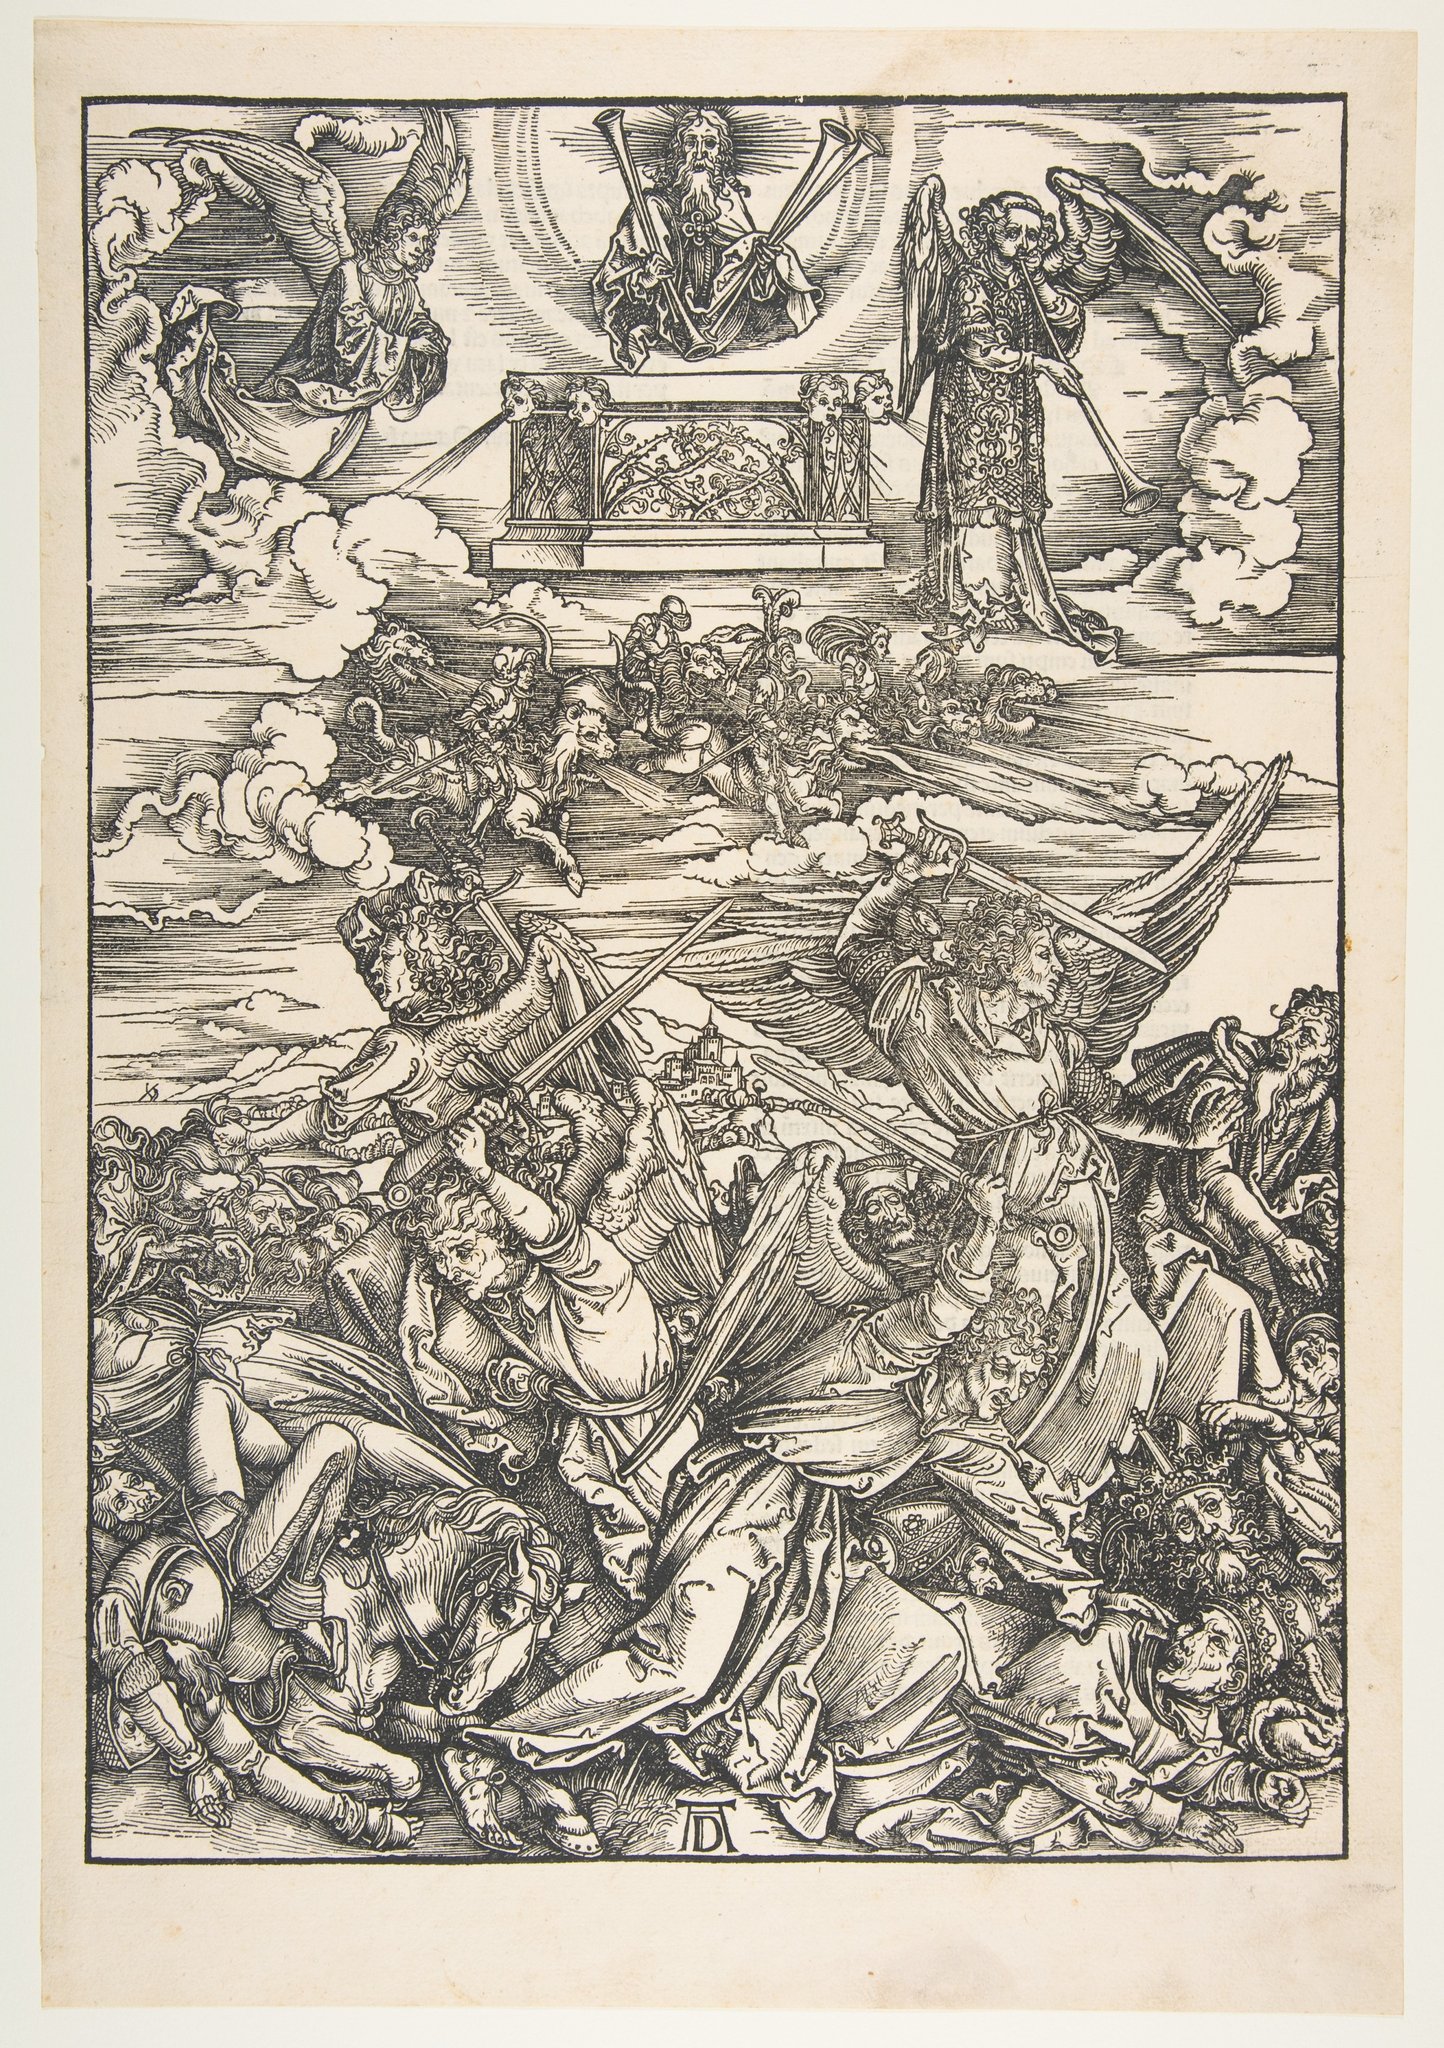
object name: print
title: The Four Avenging Angels, from "The Apocalypse"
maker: albrecht dürer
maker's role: artist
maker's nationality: german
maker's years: 1471-1528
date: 1498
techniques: woodcut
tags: human figures,musical instruments,horses,angels,apocalypse